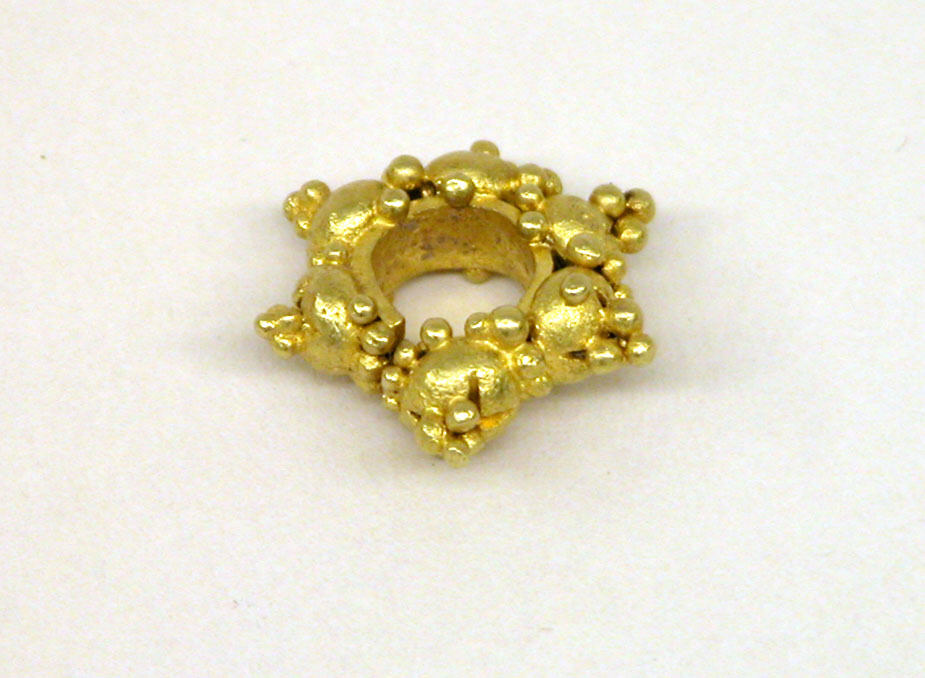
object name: ear ornament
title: Ear Ornament with Beaded Design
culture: indonesian, javanese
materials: gold